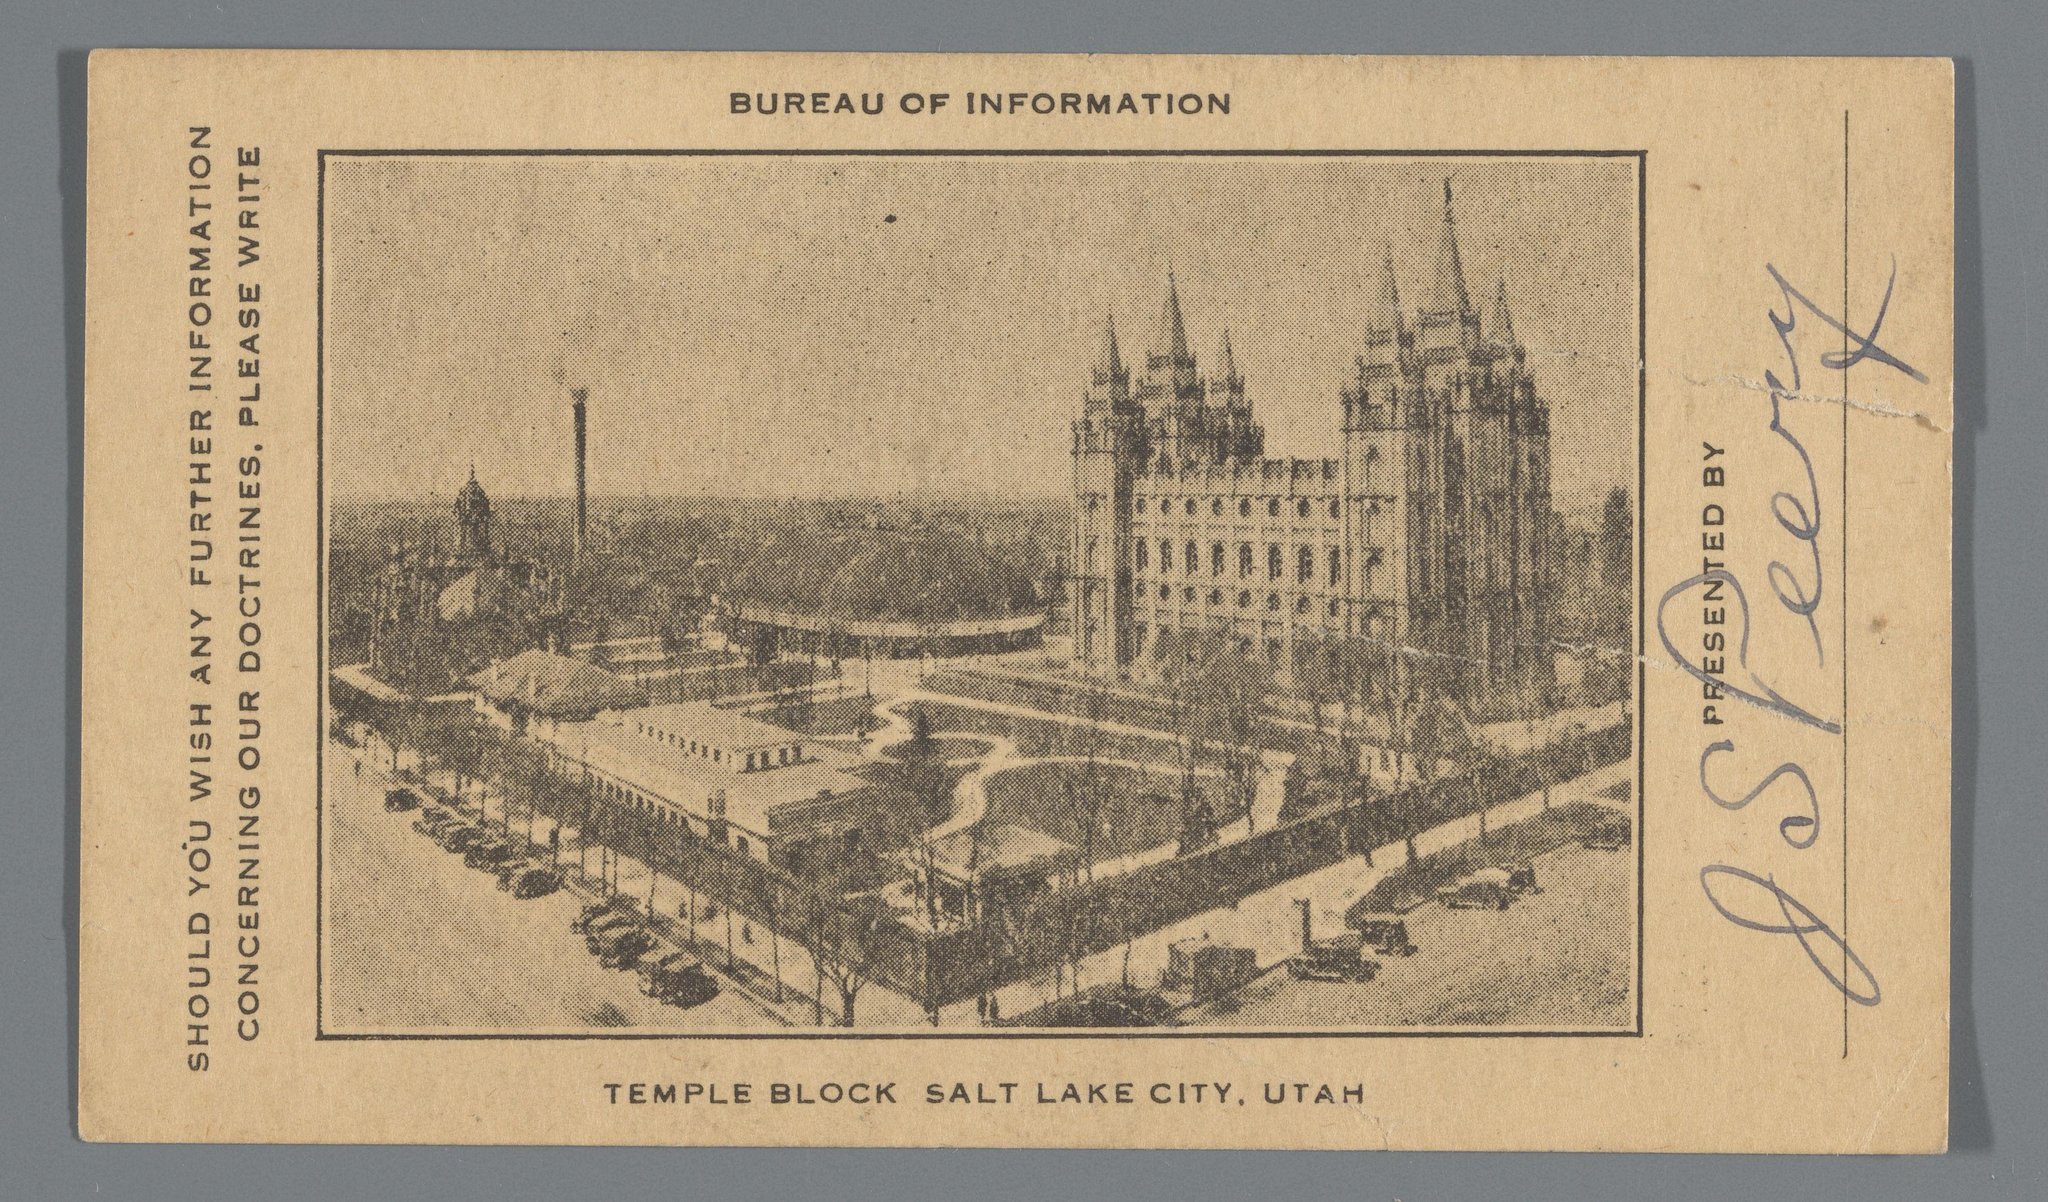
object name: photomechanical print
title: Temple block Salt Lake City, Utah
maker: Anonymous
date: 1900-1930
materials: paper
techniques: autotype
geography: united states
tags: movements derived from protestant churches (with name)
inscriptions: inscription: ‘Bureau of Information/ Should you wish (...) presented by’, inscription: ‘J.S. Peery’, inscription: ‘Articles of Faith/ Of the Church of Jesus Christ of Latter-day Saints (...) we seek after these things.’